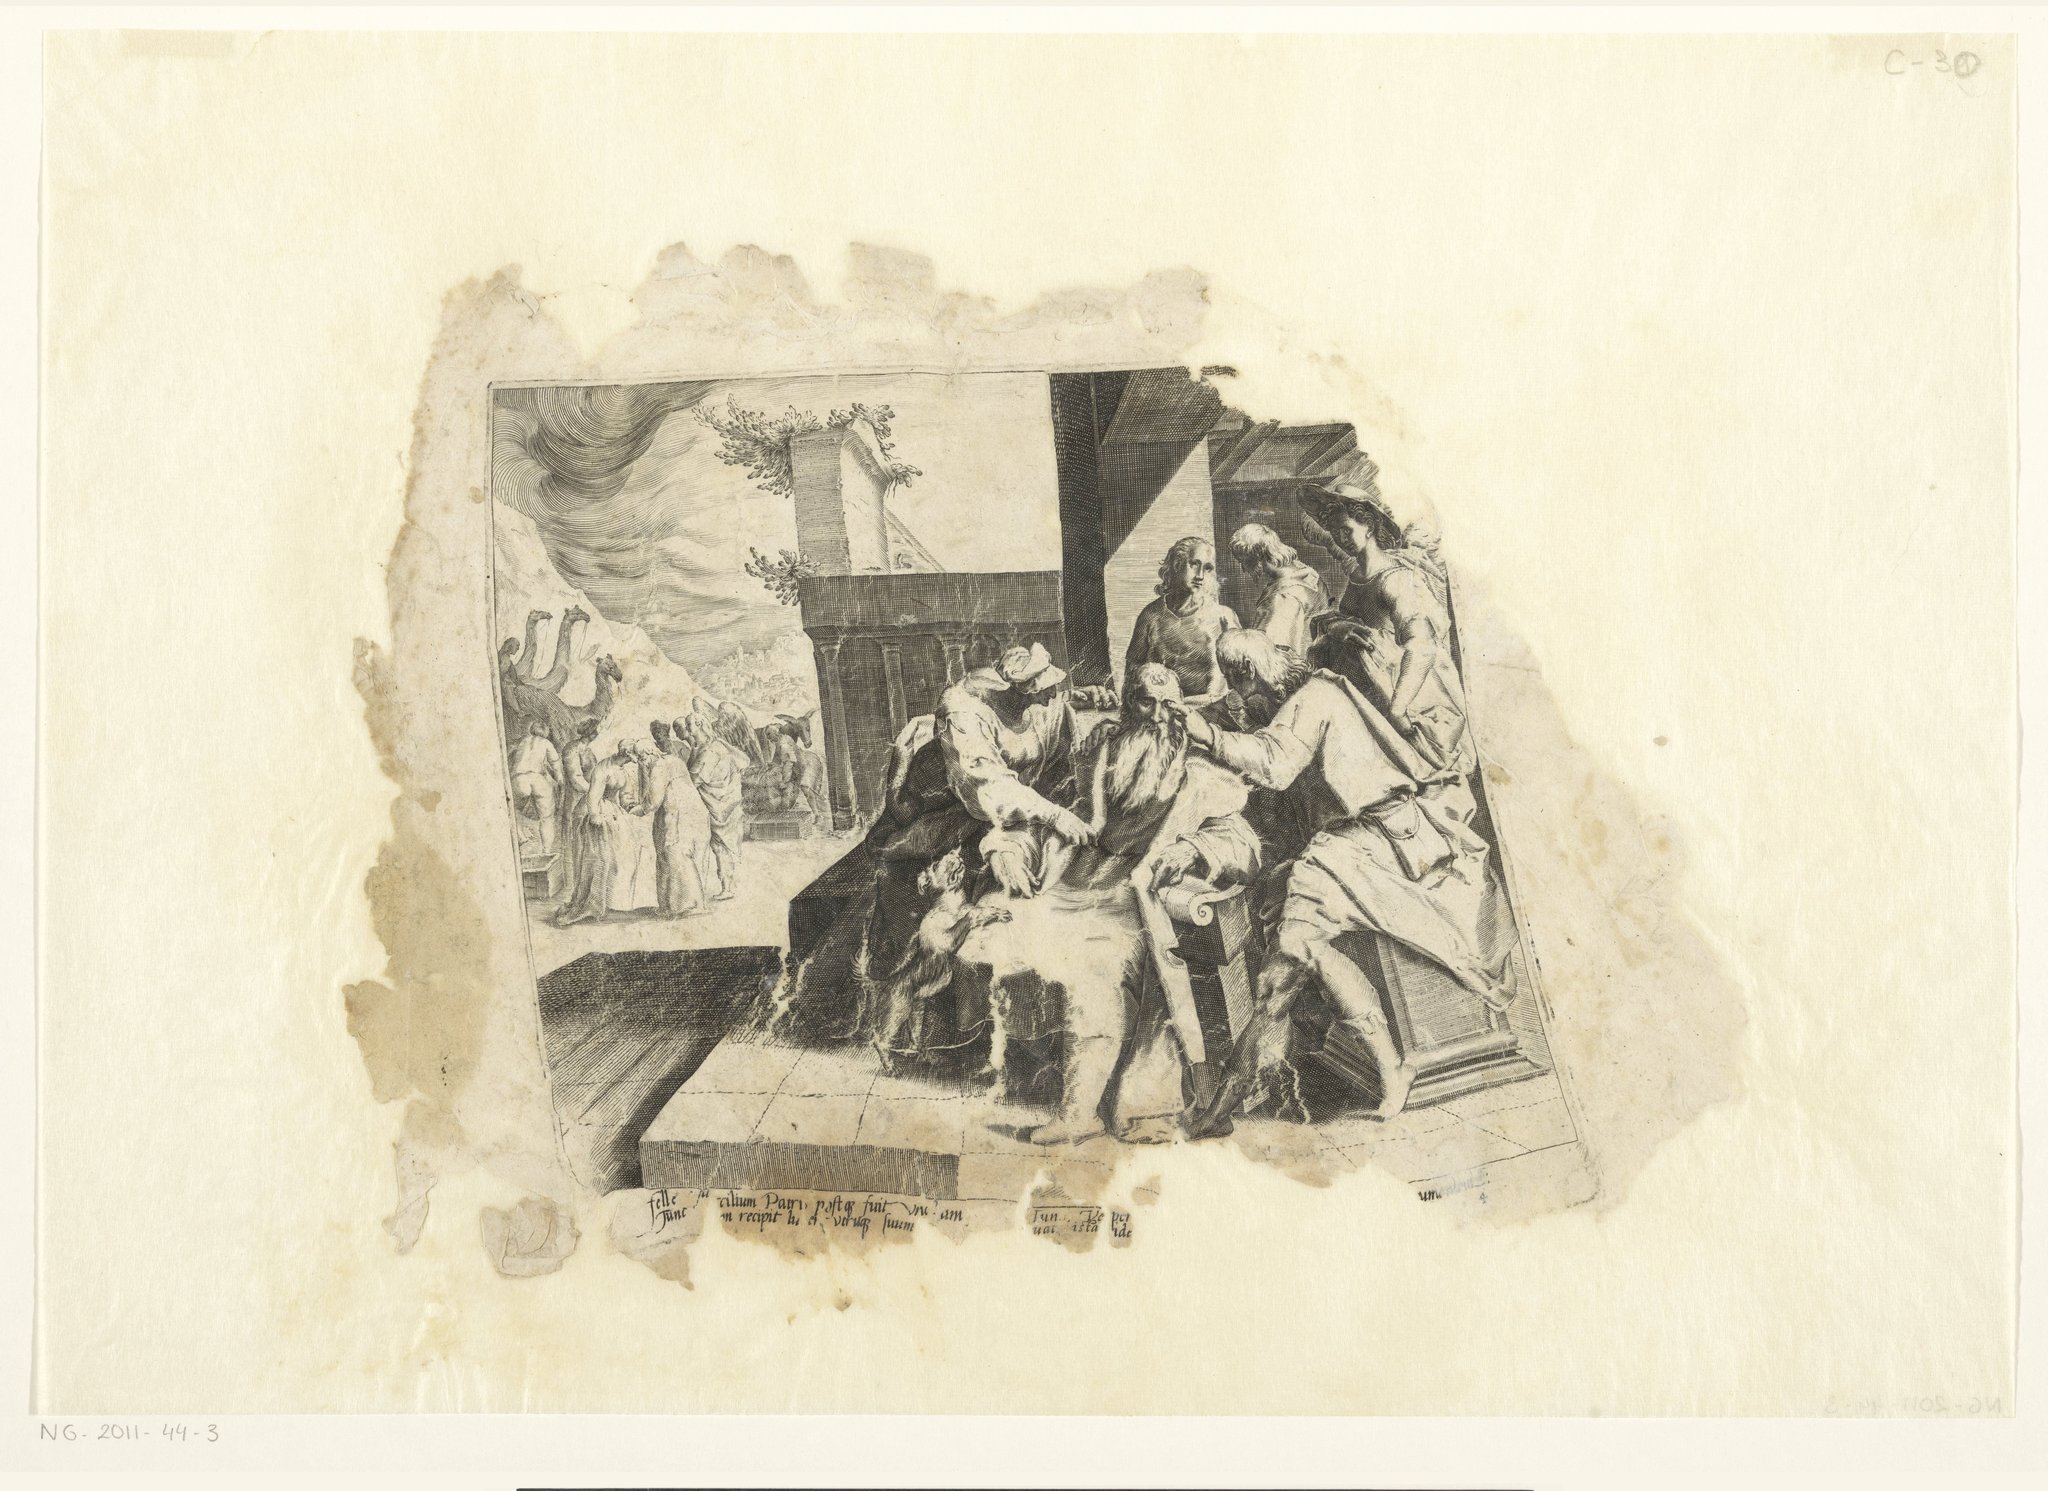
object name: print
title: Geschiedenis van Tobias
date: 1580-1596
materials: paper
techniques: engraving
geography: amsterdam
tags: the healing of tobit: tobias puts the gall of the fish on his father's eyes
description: De prenten in de Nova Zembla collectie zijn tijdens een expeditie van Willem Barendsz en Jacob van Heemskerk in 1596-1597 noodgedwongen in het winterkamp, het ‘Behouden Huis’, op het eiland achtergelaten. De prenten waren in één of meerdere stapels als handelswaar meegenomen vanuit Amsterdam. Bijna drie eeuwen later, in 1871, keerde de Noor Elling Carlsen terug naar Nova Zembla en vond daar de restanten van het ‘Behouden Huis, inclusief een groot deel van de inventaris. Een deel van de prenten, in de vorm van aaneengekoekte kluiten, werd toen ook teruggevonden. De papierkluiten waren soms op meerdere plekken gebroken. Tussen 1975-1979 zijn de prenten van elkaar gescheiden. Dit leverde in totaal ca. 1000 fragmenten van ca. 400 afdrukken van ca. 150 verschillende prenten op. Voor zover mogelijk zijn de fragmenten samengevoegd en zijn de prenten gereconstrueerd.